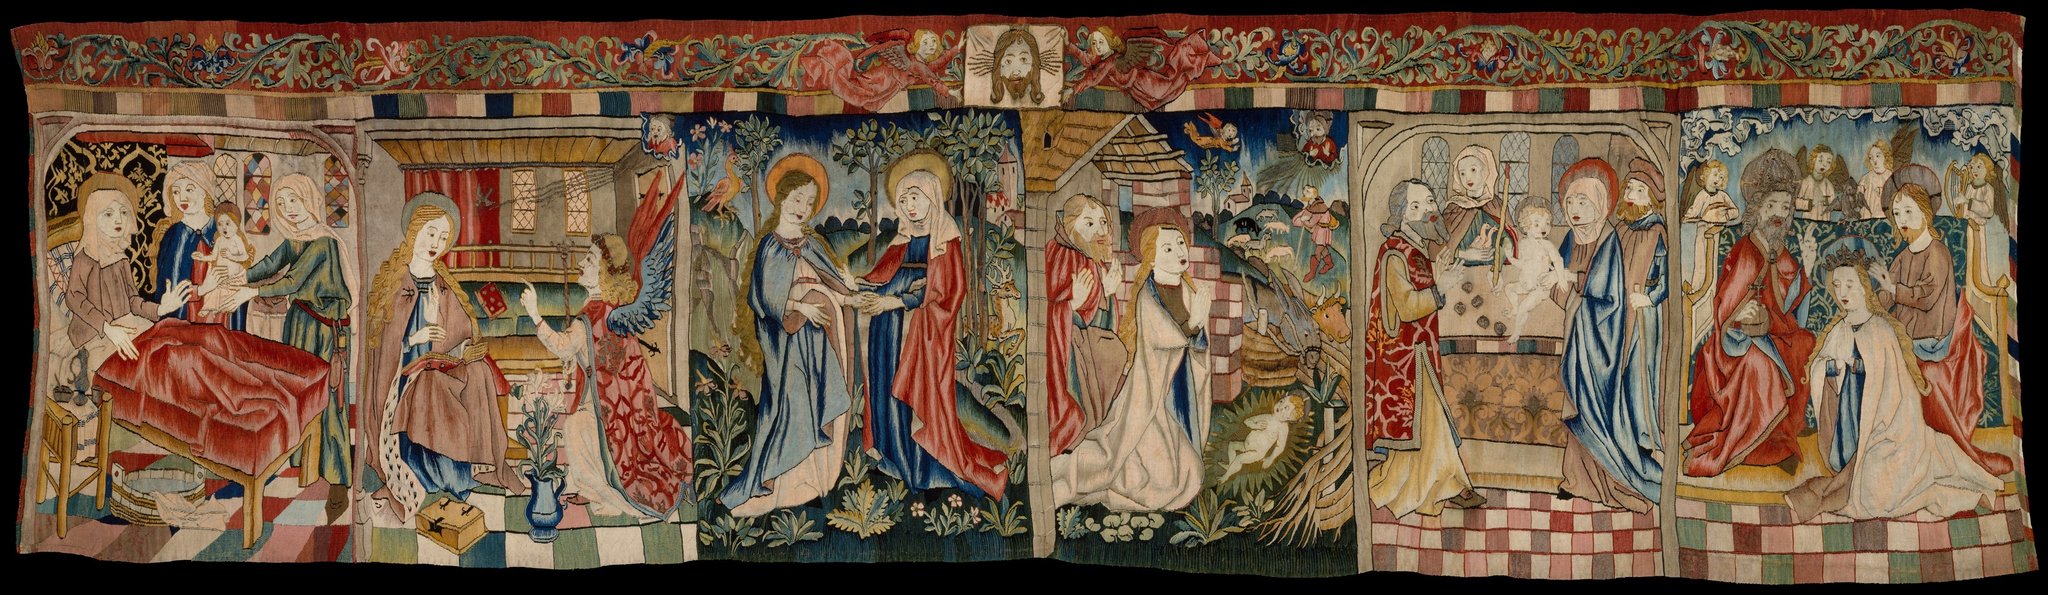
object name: antependium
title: Scenes from the Life of the Virgin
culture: upper rhenish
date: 1500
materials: gilt, linen, silk, silver, wool, thread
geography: france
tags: angels,christ,virgin mary,archangel gabriel,annunciation,nativity,visitation,coronation of the virgin